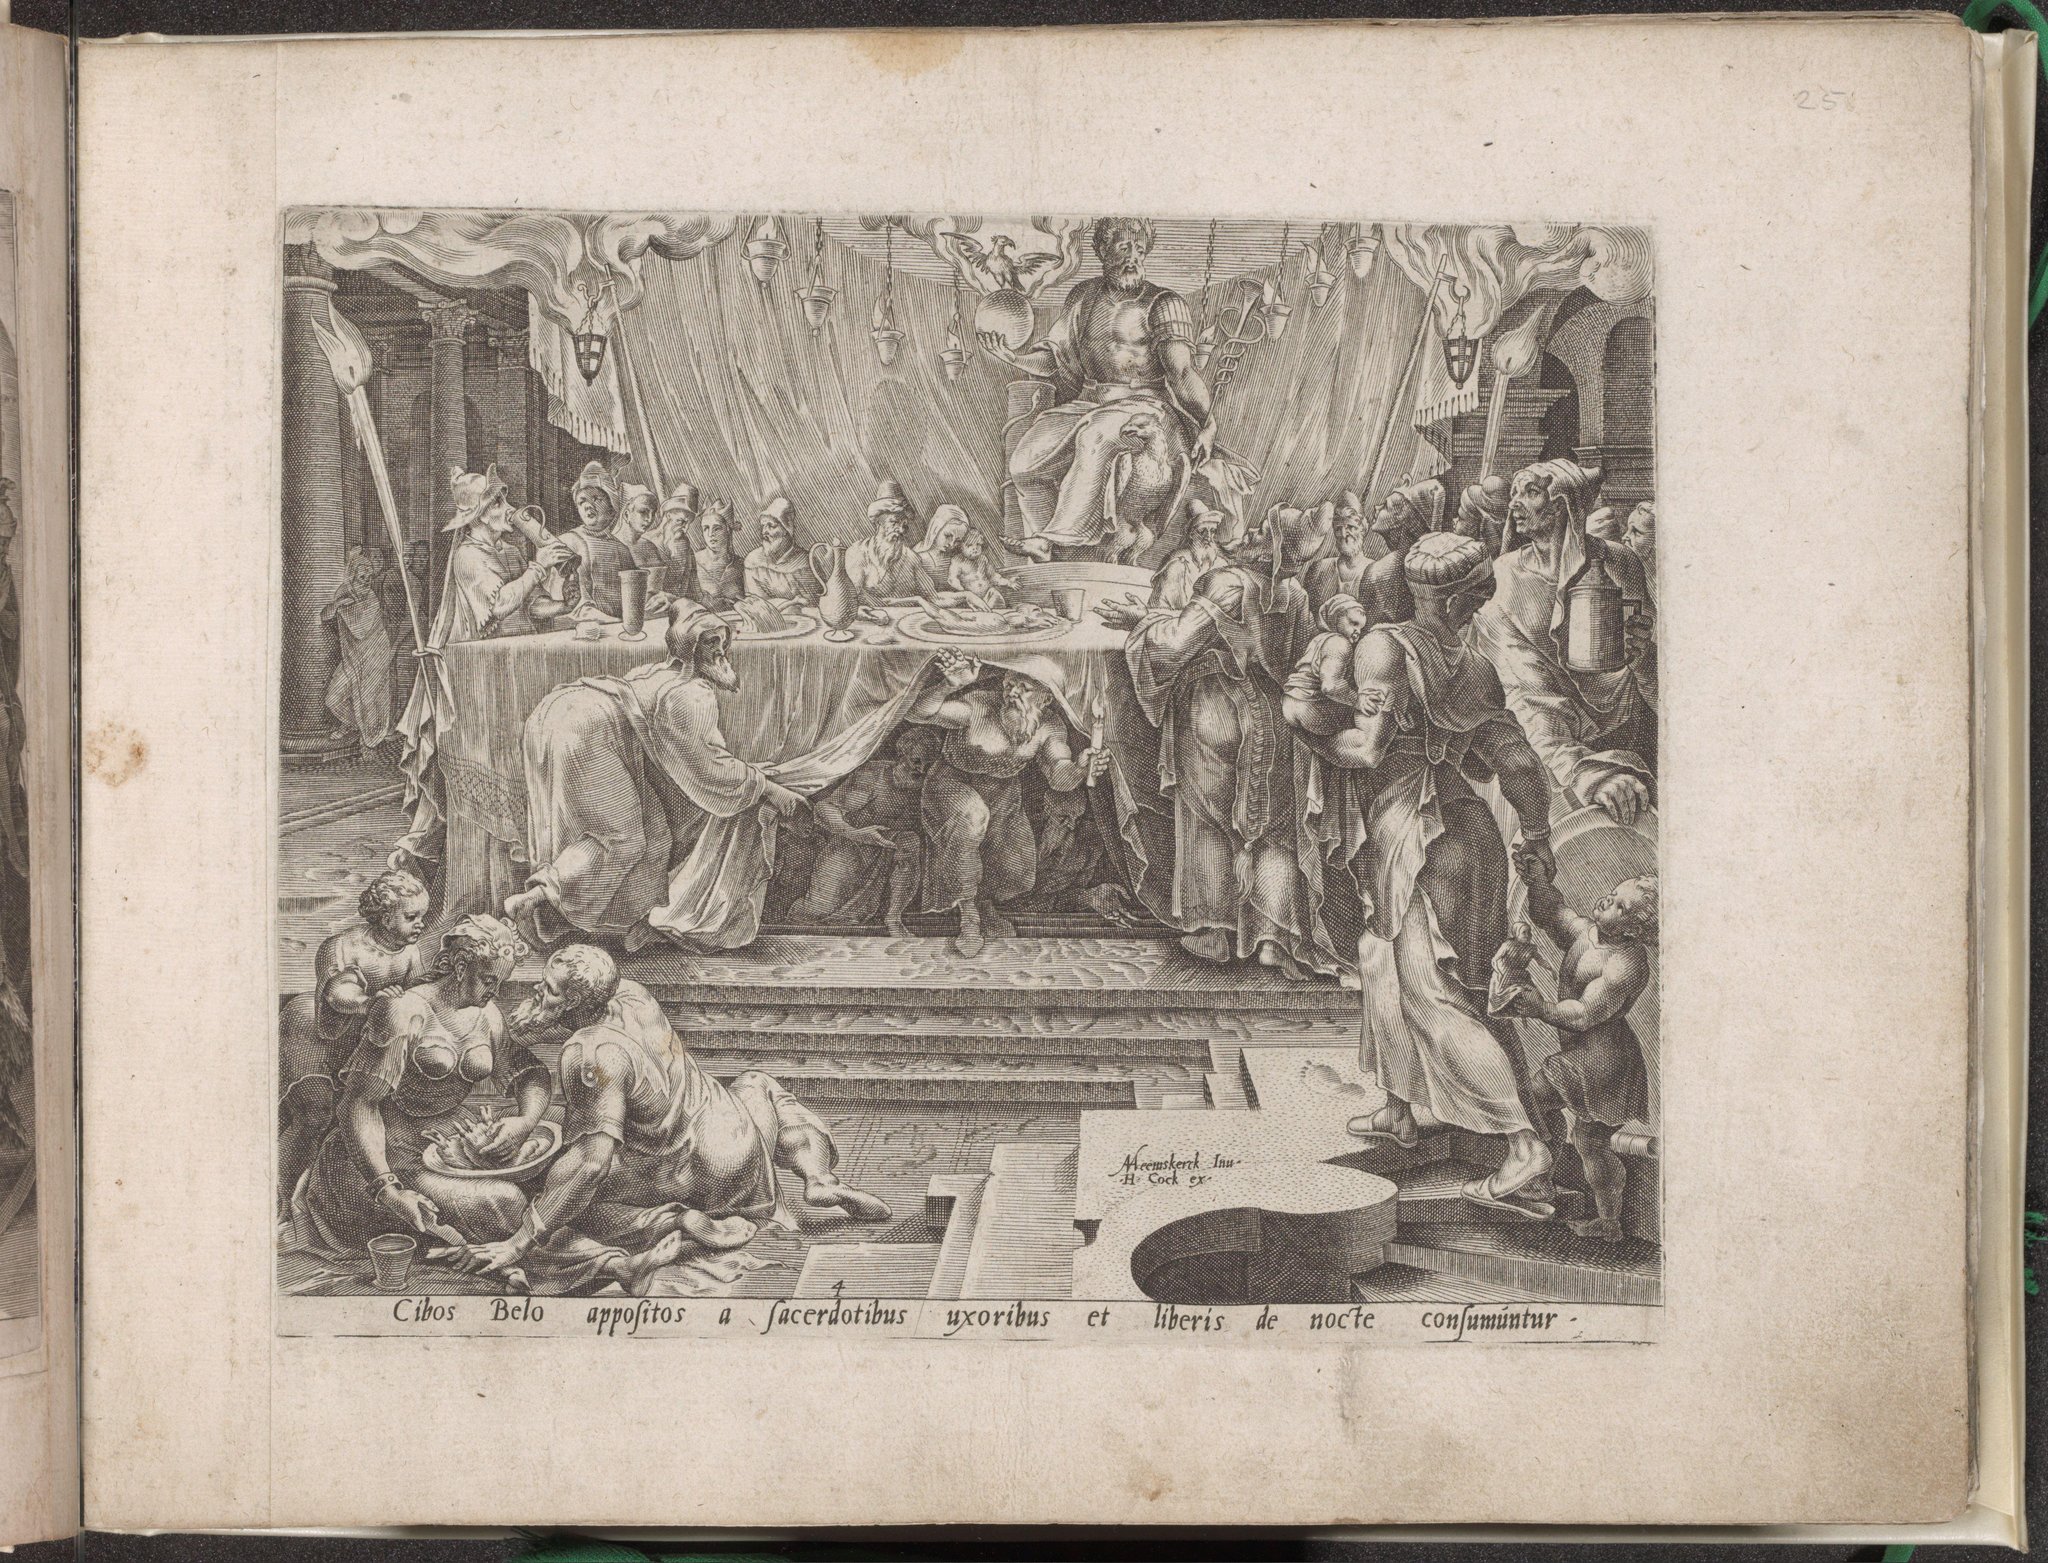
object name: album leaf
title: Geschiedenis van Daniël, Bel en de draak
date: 1565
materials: paper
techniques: engraving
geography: antwerp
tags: the priests of bel, with their wives and children, enter the temple through a hidden corridor and feast on the food during the night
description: De priesters van Bel eten het aan de god Bel geofferde voedsel. Ze komen en gaan door een geheime gang onder de tafel. Terwijl ze heimelijk het voedsel nemen, blijven hun voetstappen achter in de door Daniël op de grond gestrooide as. Onder de voorstelling een verklarende tekst in het Latijn. Deze prent maakt deel uit van een album.